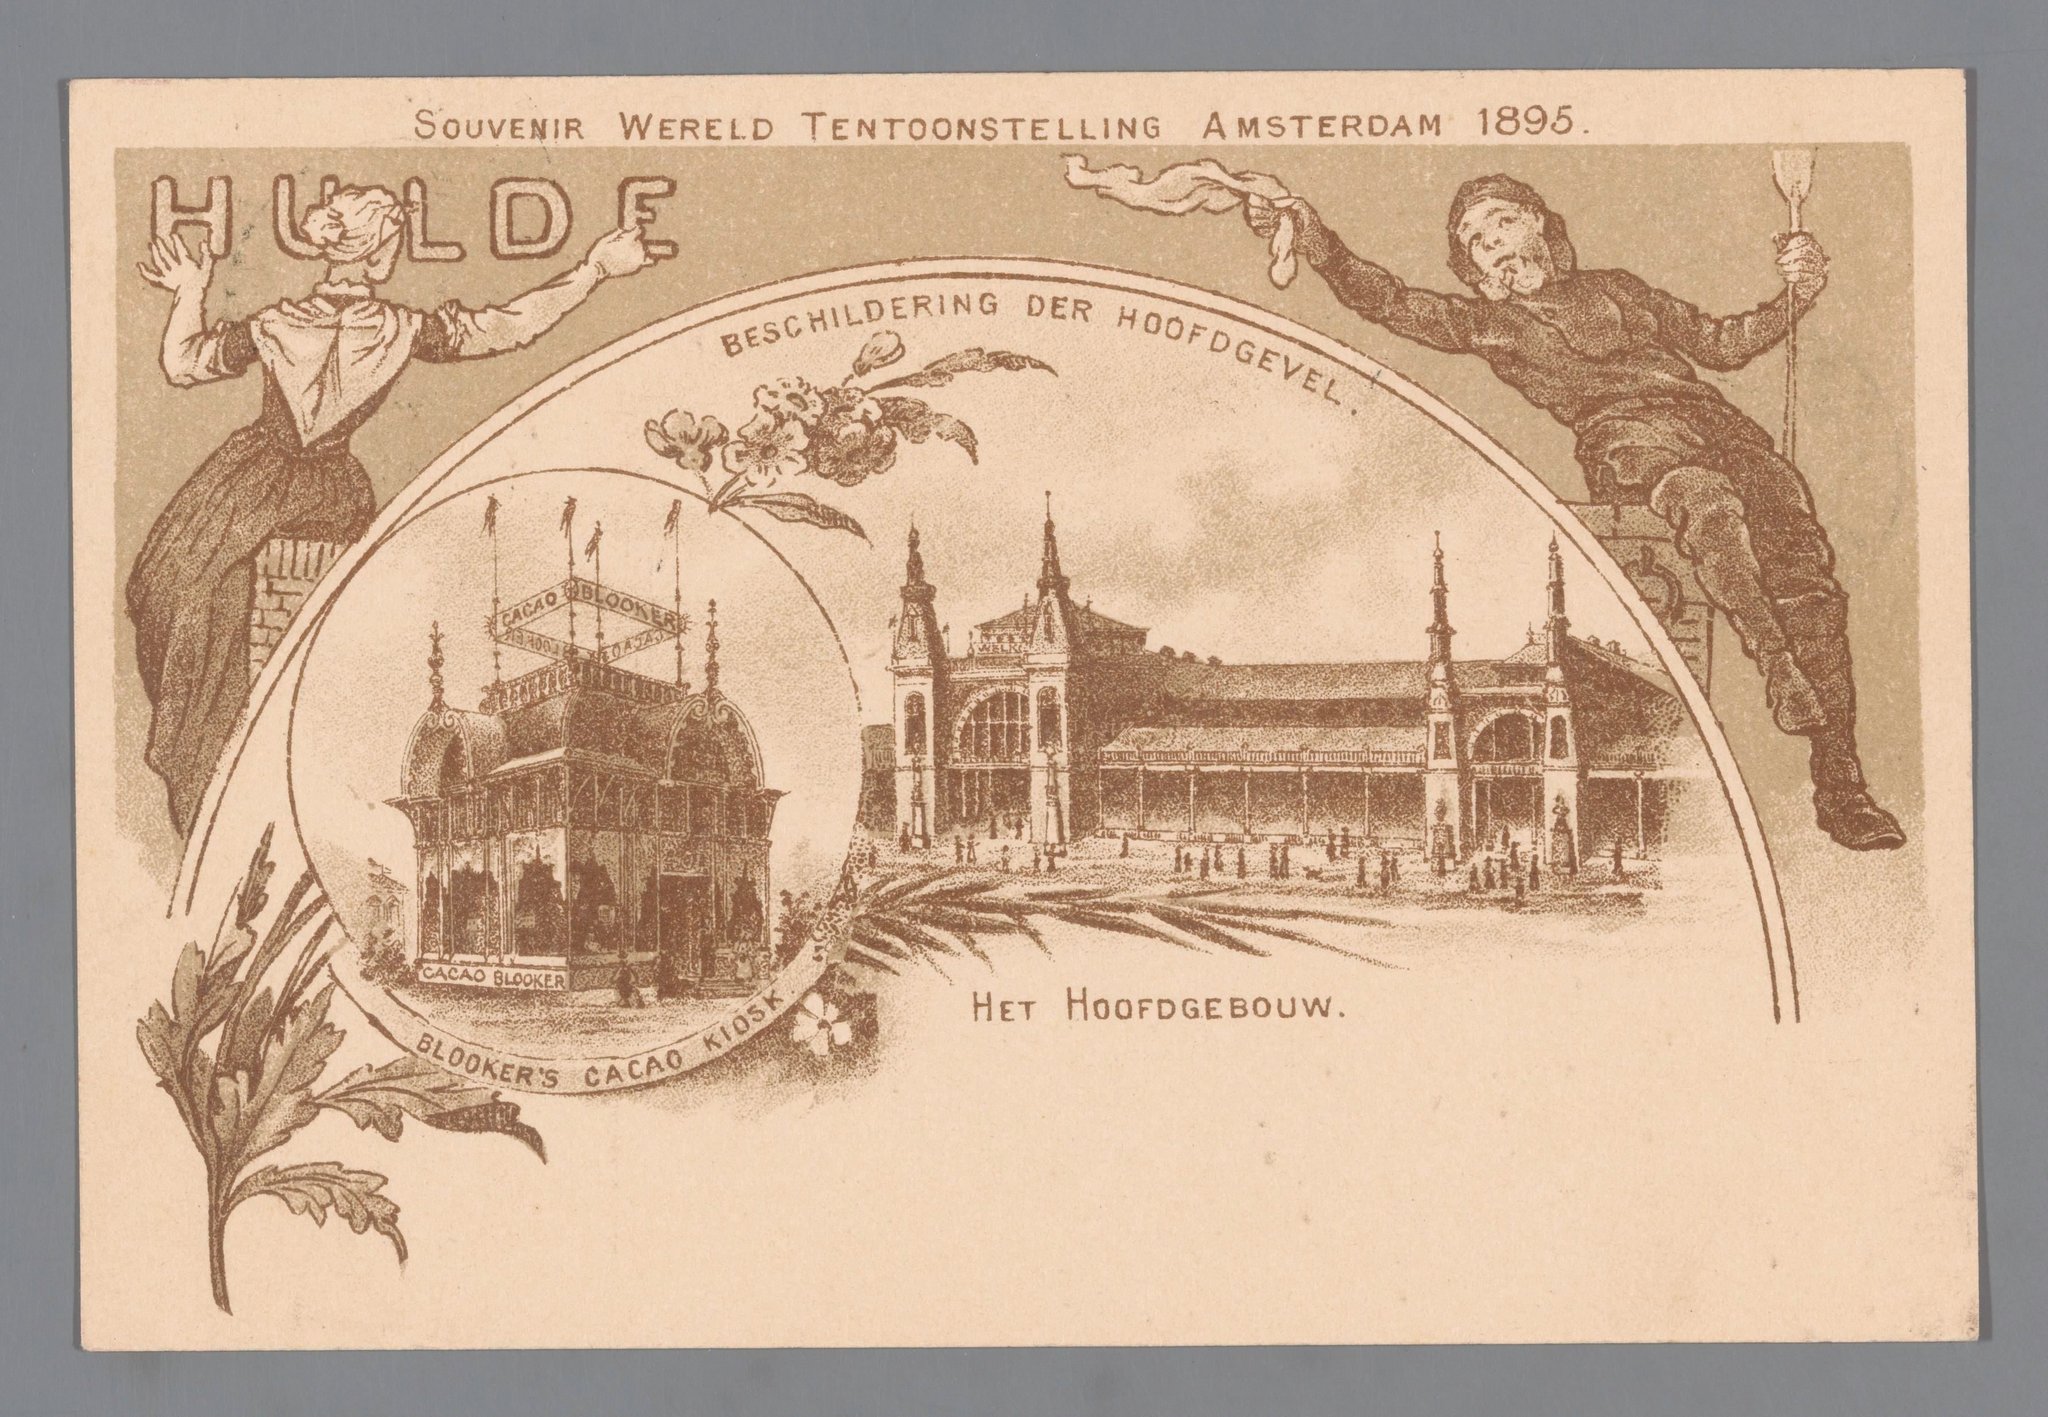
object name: ansichtkaart, prentbriefkaart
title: Souvenir Wereld Tentoonstelling Amsterdam 1895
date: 1895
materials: cardboard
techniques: printing block, writing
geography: amsterdam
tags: world fair, world exhibition, amsterdam